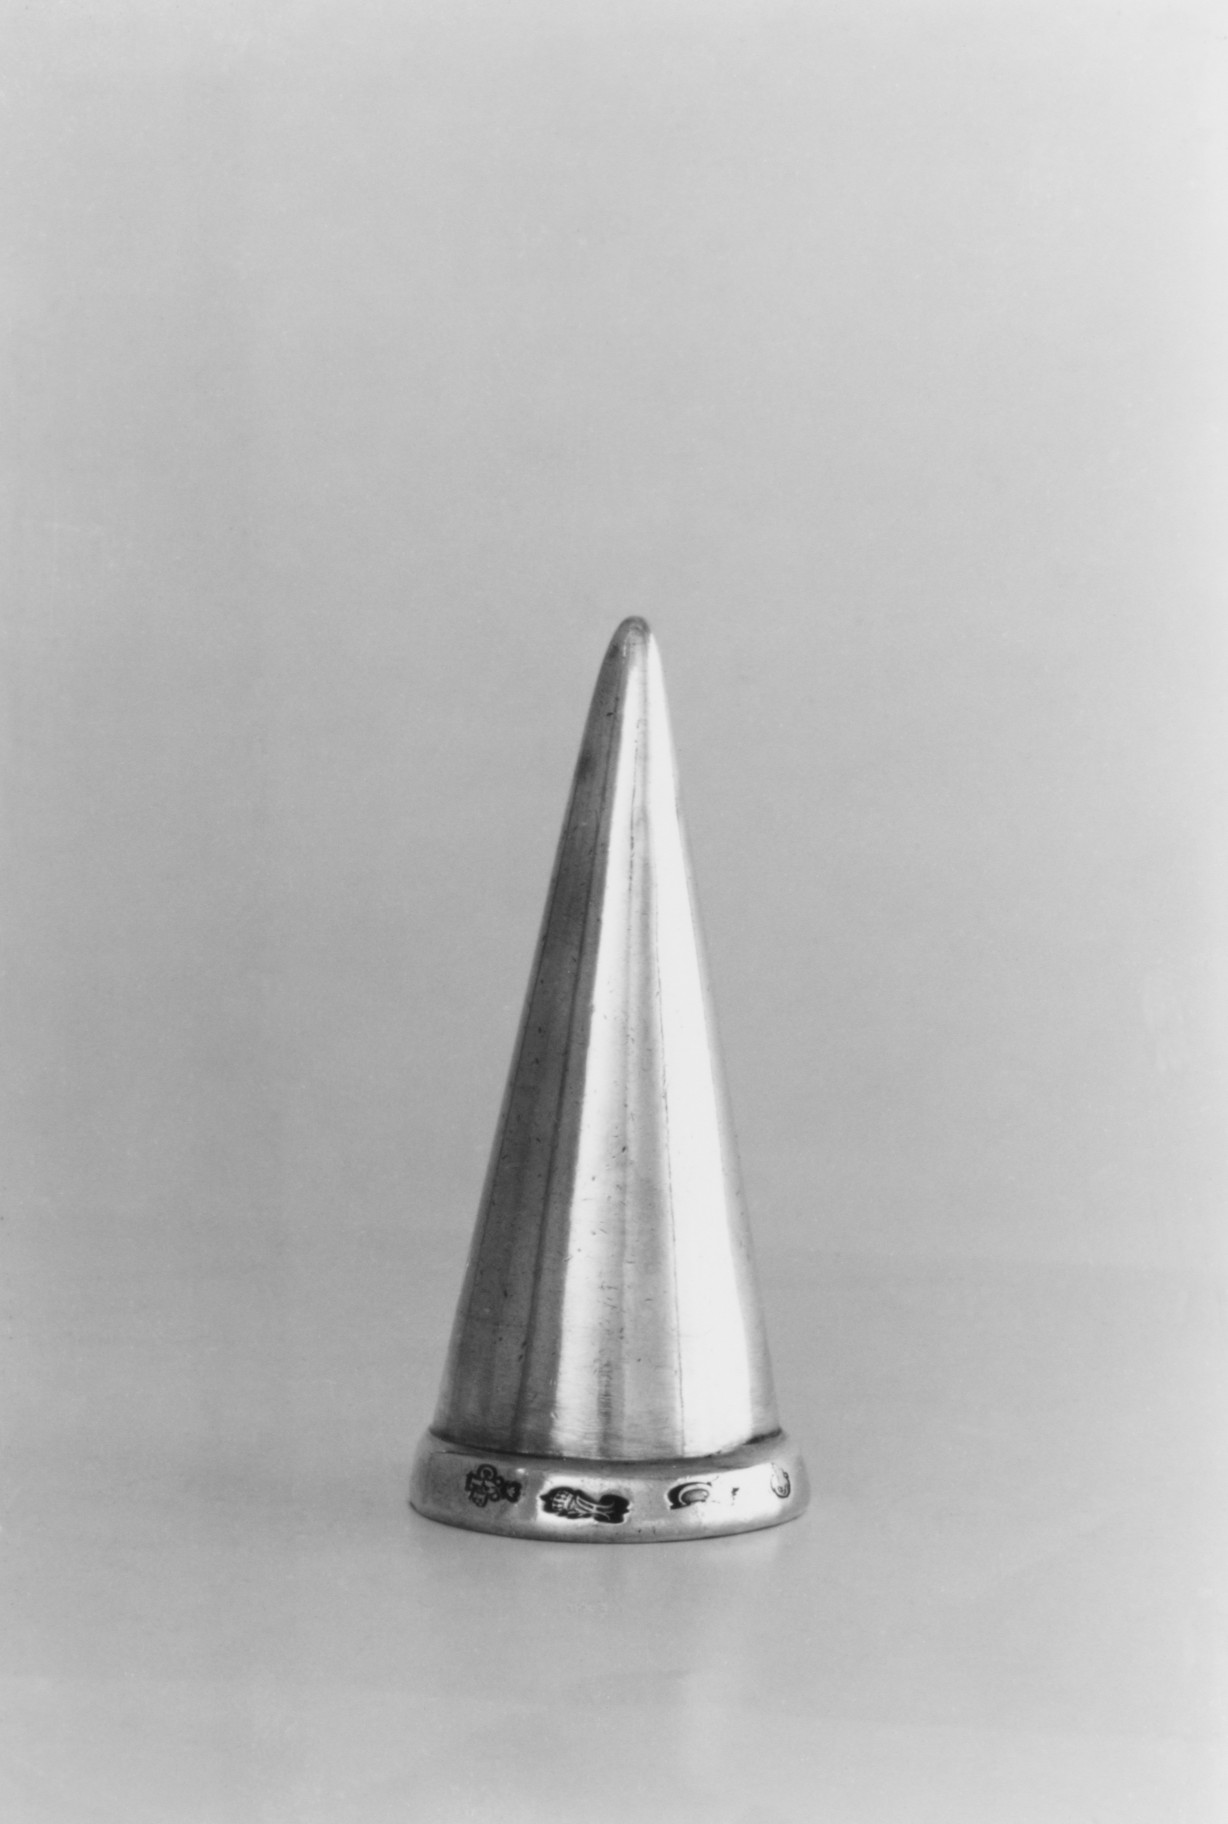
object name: candle extinguisher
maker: charles-françois lautran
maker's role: maker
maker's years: 1677-1777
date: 1766-1767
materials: silver